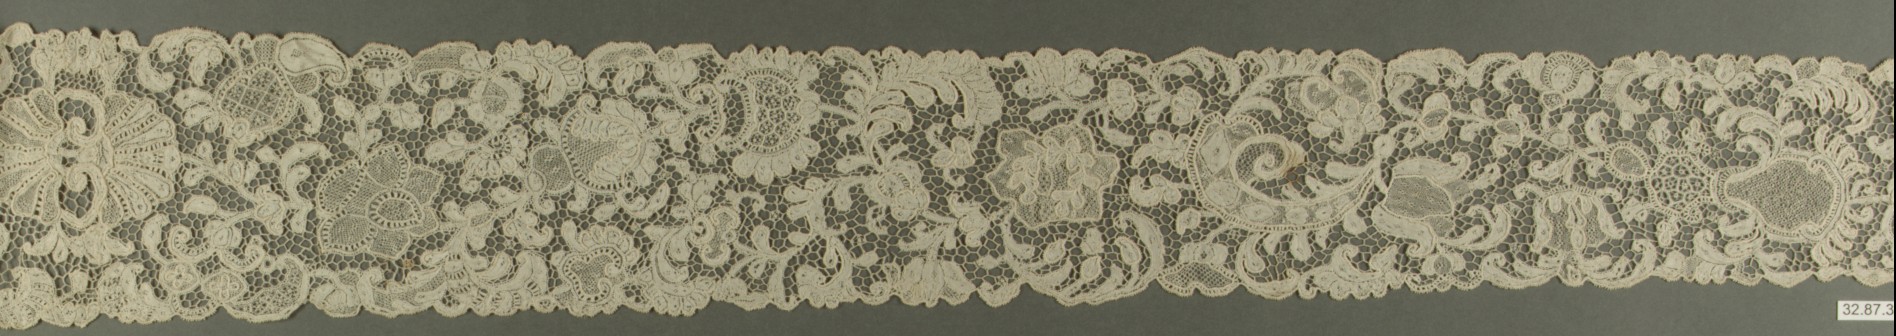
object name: barbe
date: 1700-1750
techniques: lace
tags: flowers